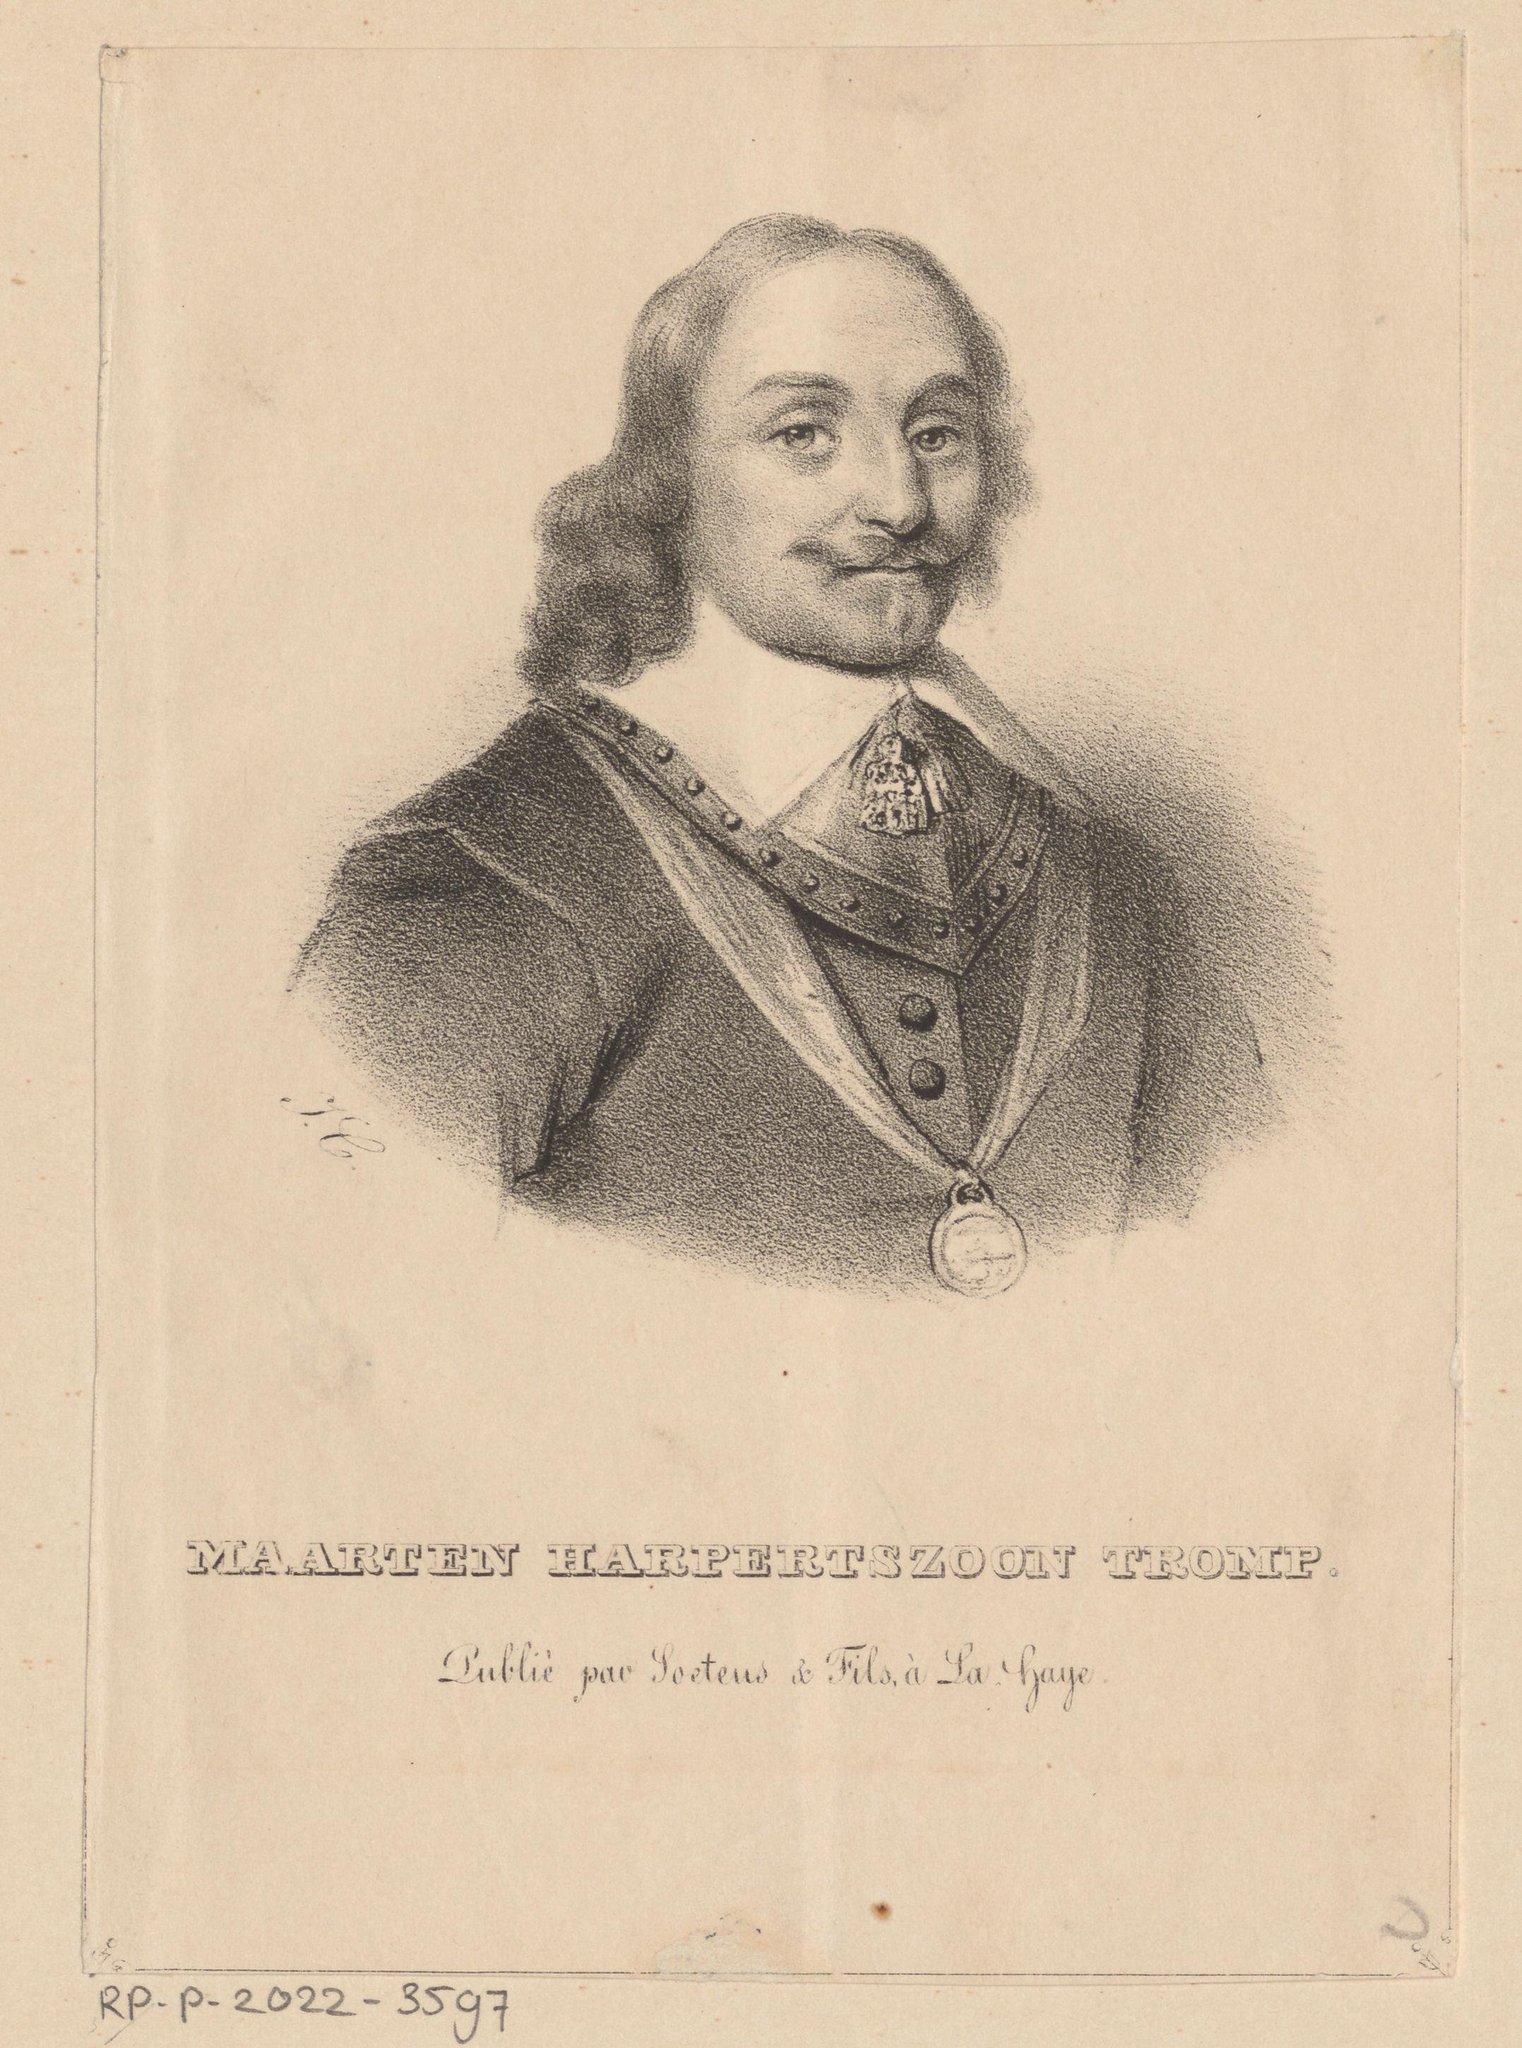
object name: print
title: Serie portretten door Soetens & Fils omstreeks 1838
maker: j.b. clermans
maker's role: print maker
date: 1838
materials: paper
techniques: lithograph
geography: netherlands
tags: brielle, maarten harpertszoon tromp, historical persons, medals and other marks of military honour, commander-in-chief, admiral